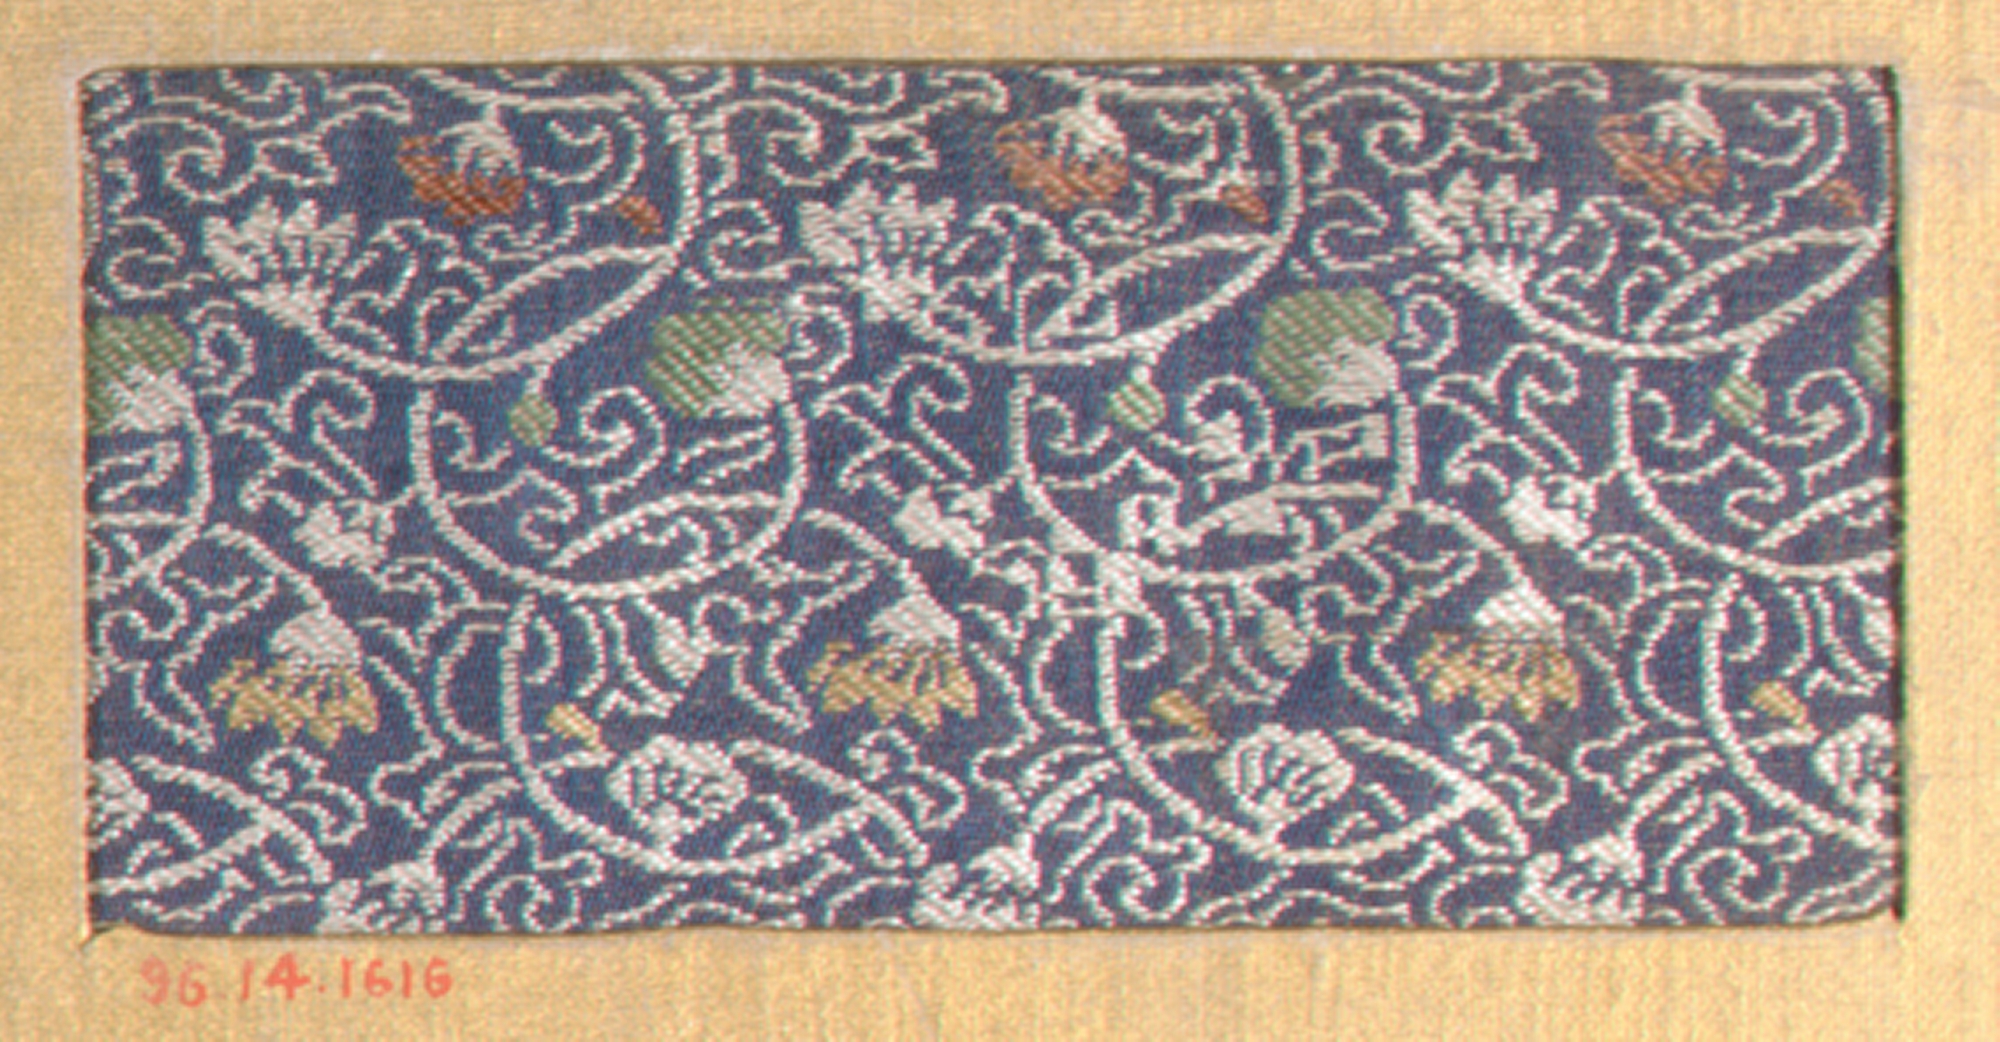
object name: piece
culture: japanese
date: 1701-1900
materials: silk